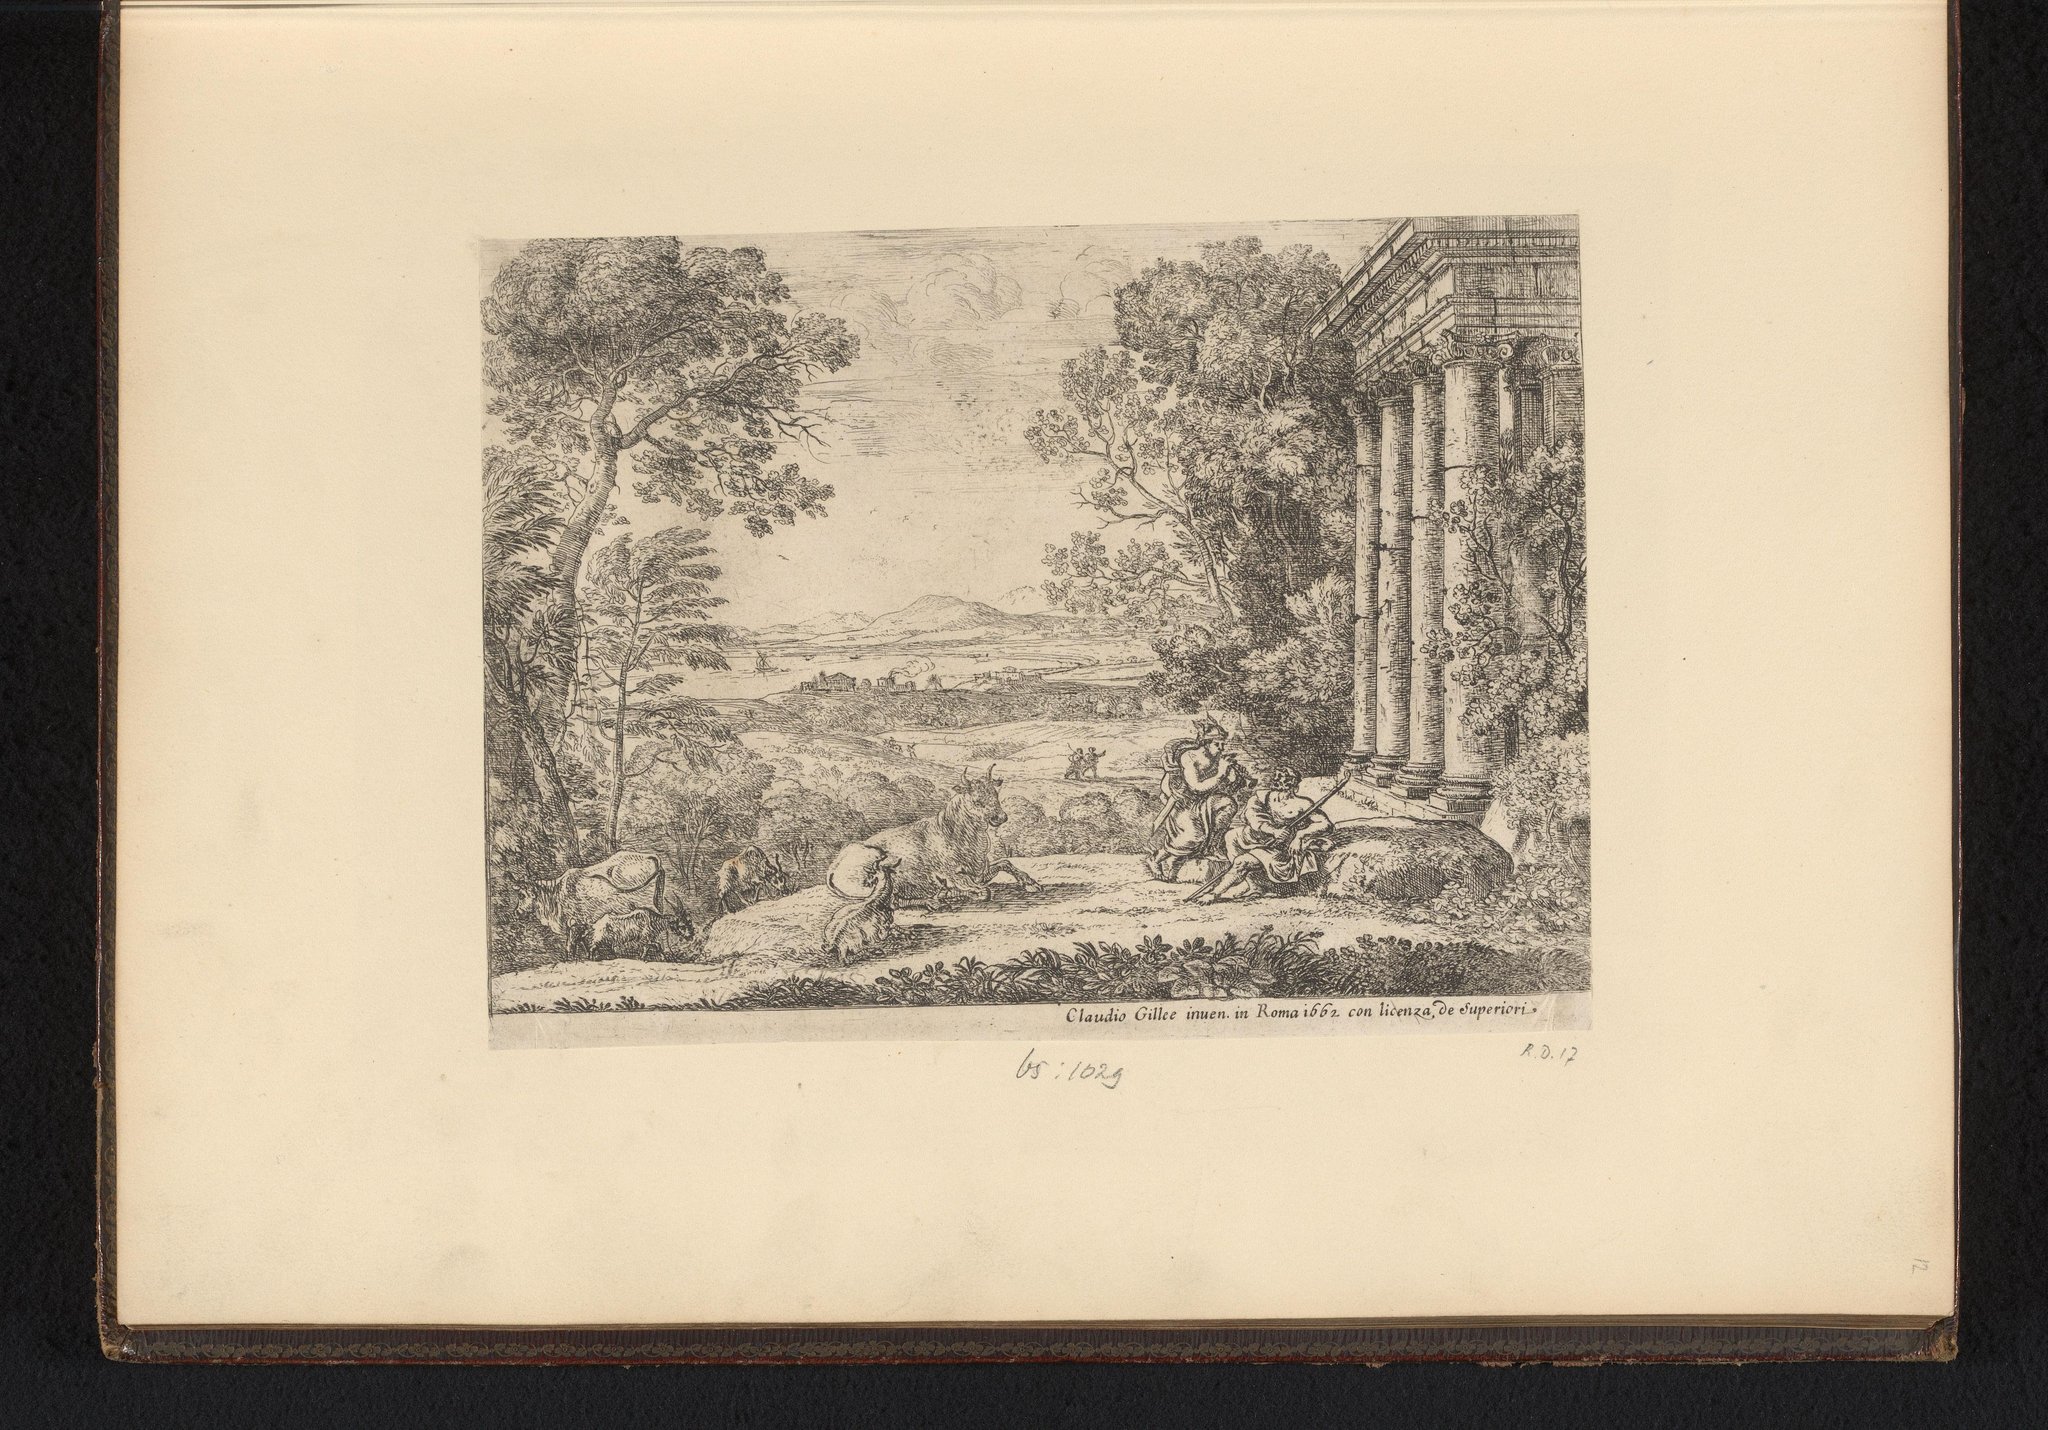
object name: album leaf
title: Mercurius en Argus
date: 1662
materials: paper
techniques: etching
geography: rome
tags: mercury lulls argus into sleep by making music, landscape with ruins (+ city(-scape) with figures, staffage)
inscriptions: date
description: Argus zit op een steen bij de ingang van een tempel. Voor hem ligt de in een koe veranderde Io. Mercurius staat naast Argus en speelt op een blaasinstrument om hem in slaap te sussen. Prent maakt deel uit van een album.